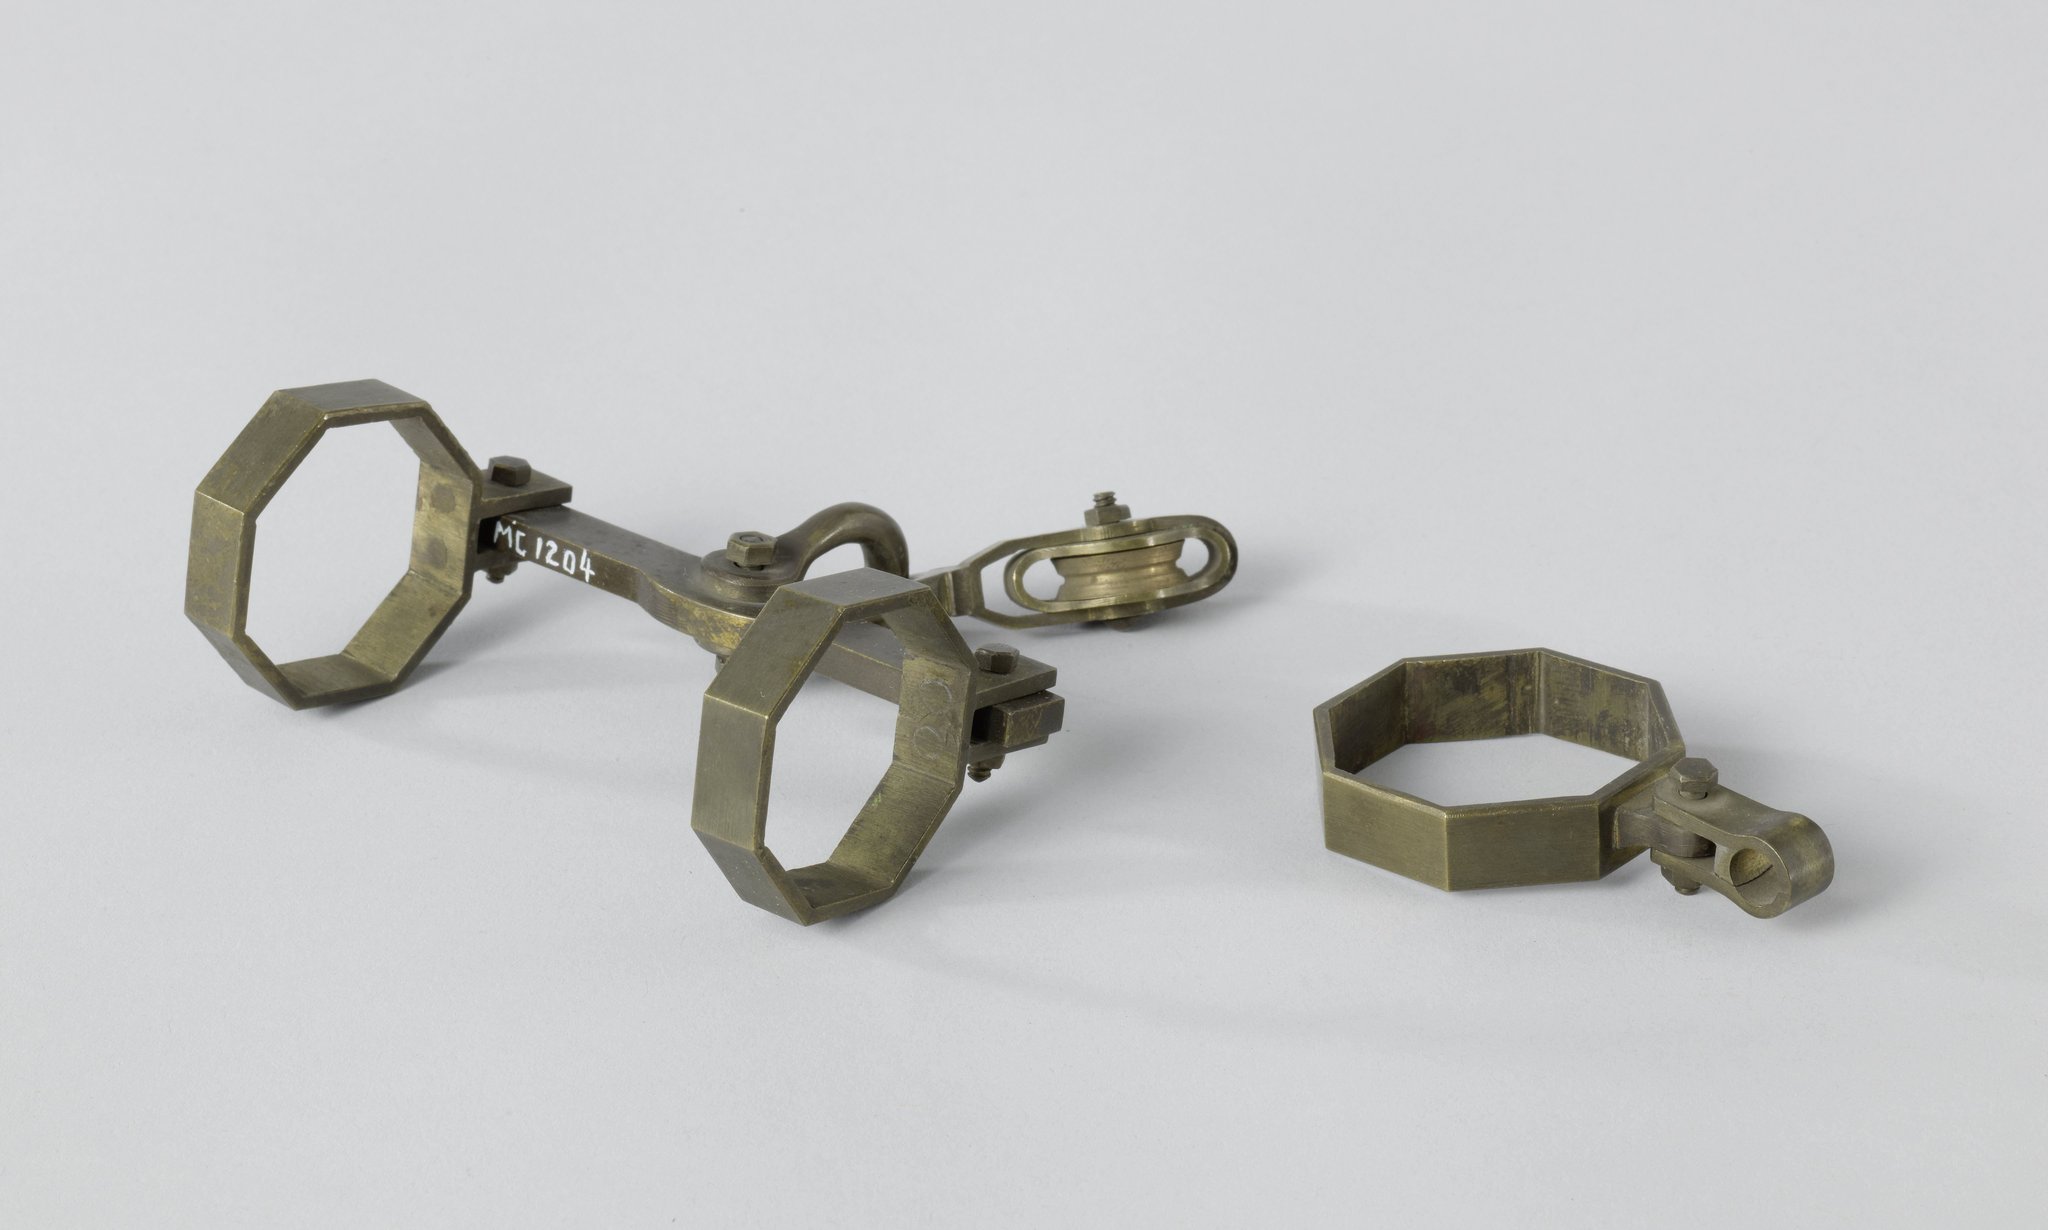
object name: demonstration model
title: Three Models of Yard Hoops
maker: Anonymous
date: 1866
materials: brass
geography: netherlands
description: Drie modellen van rabanden. De losse raband heeft een brasbeugel. De andere twee zijn verbonden door een metalen dwarsstuk, waarop in het midden een schijf van een gijn is bevestigd.